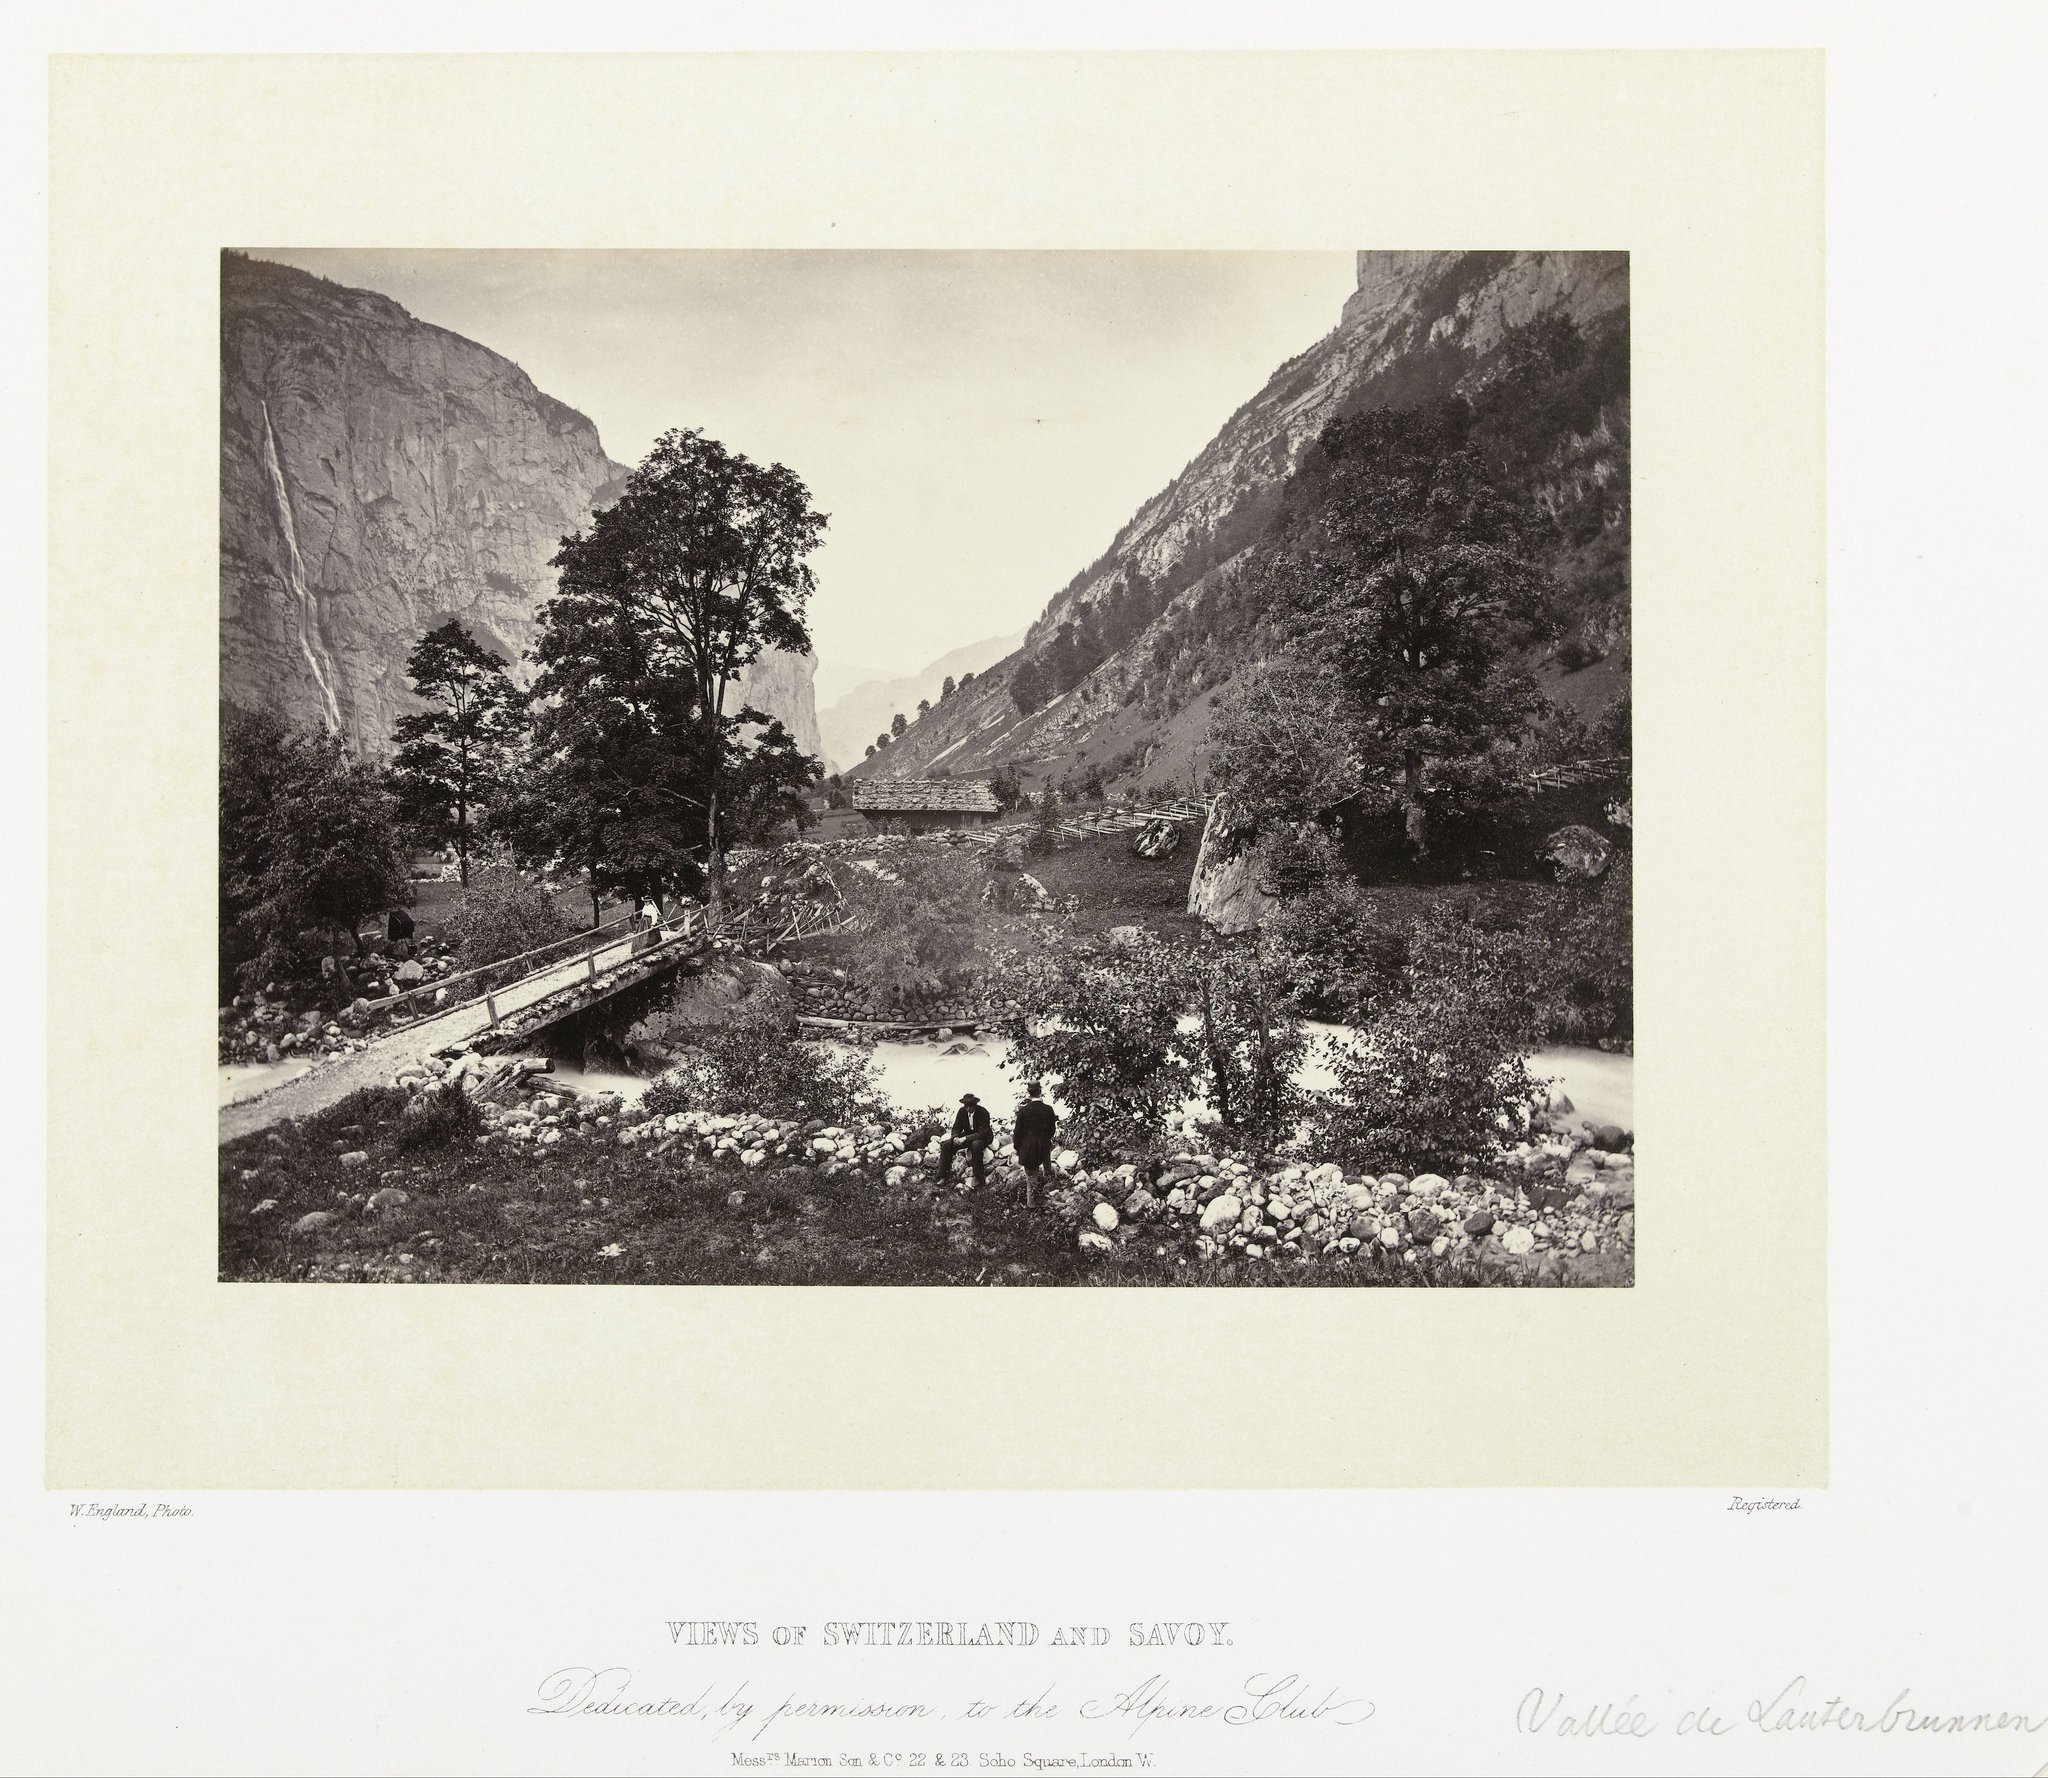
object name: photograph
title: Vallée de Lauterbrunnen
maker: william england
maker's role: fotograaf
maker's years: 1816-1896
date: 1863-1865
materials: cardboard, paper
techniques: albumen print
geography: london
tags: dale, valley, camera ~ photography, mountains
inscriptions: inscription: ‘Dedicated, by permission, to the Alpine Club’, address: ‘Messrs Marion & Co 22 & 23 Soho Square, Londo’, inscription: ‘Registered’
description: Links op de foto, aan de overzijde van het water, staat een fotocamera. De vrouw op de brug is mogelijk aan het poseren.